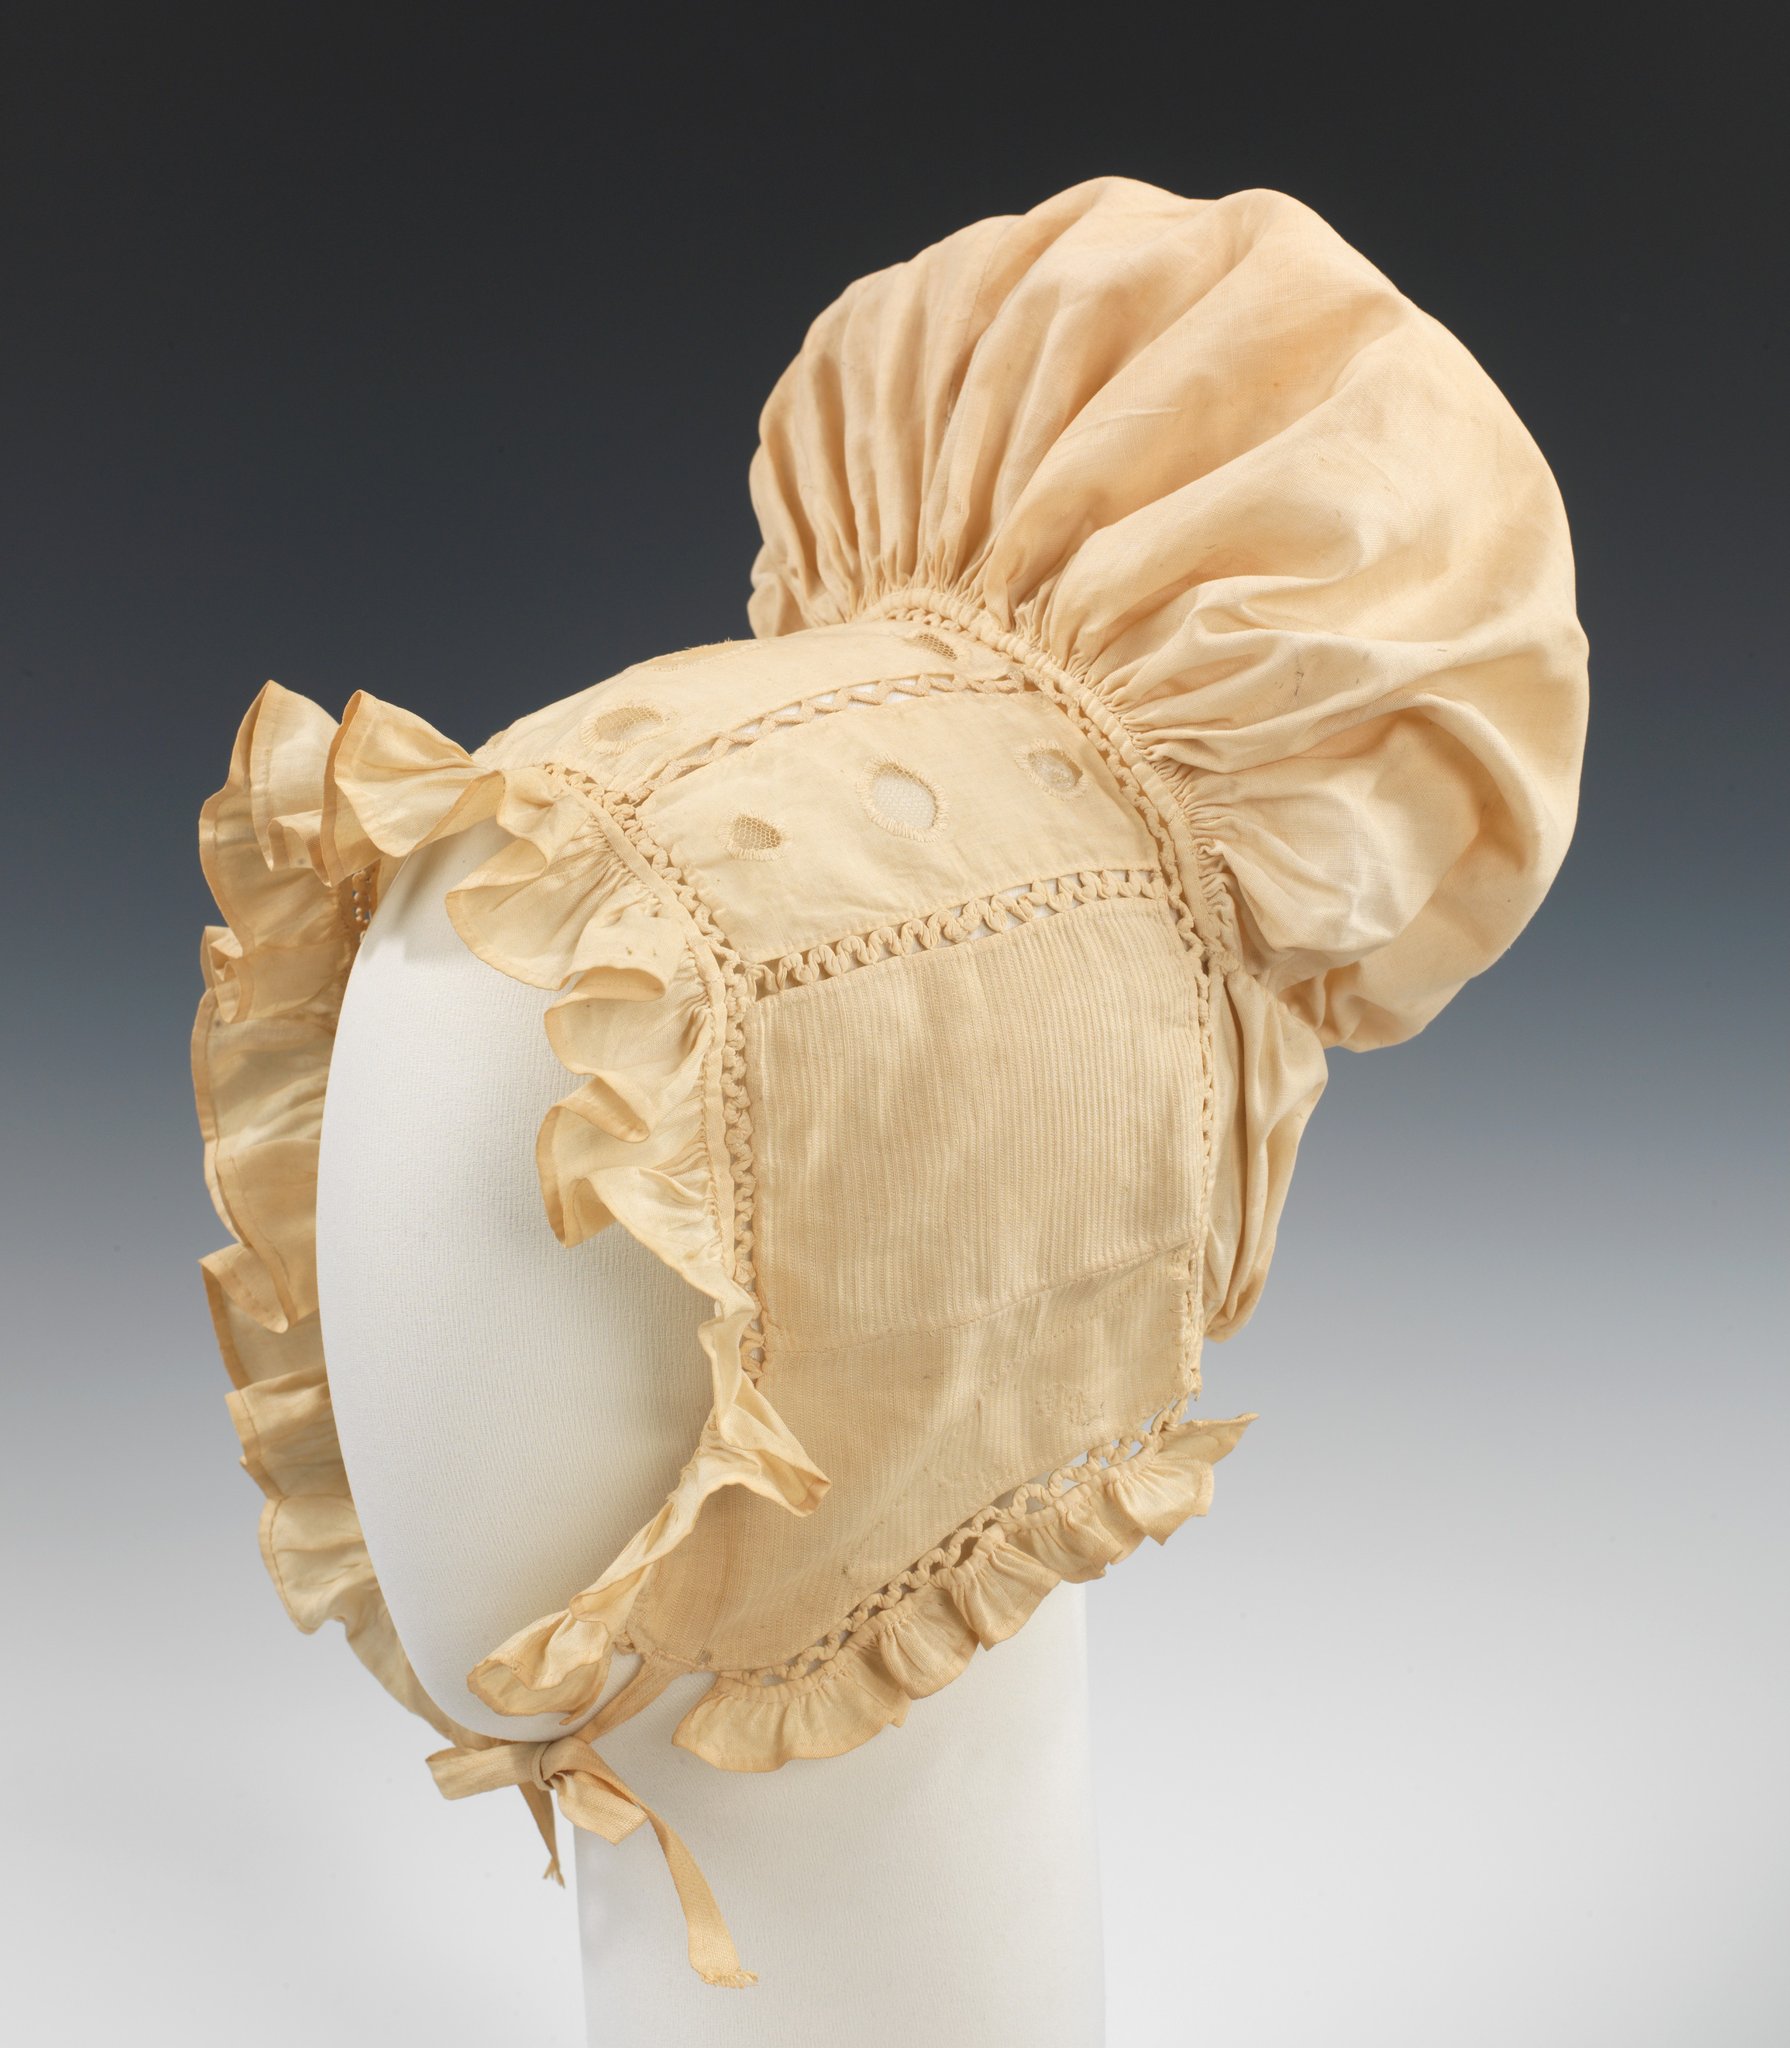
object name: sunbonnet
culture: american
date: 1825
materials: cotton